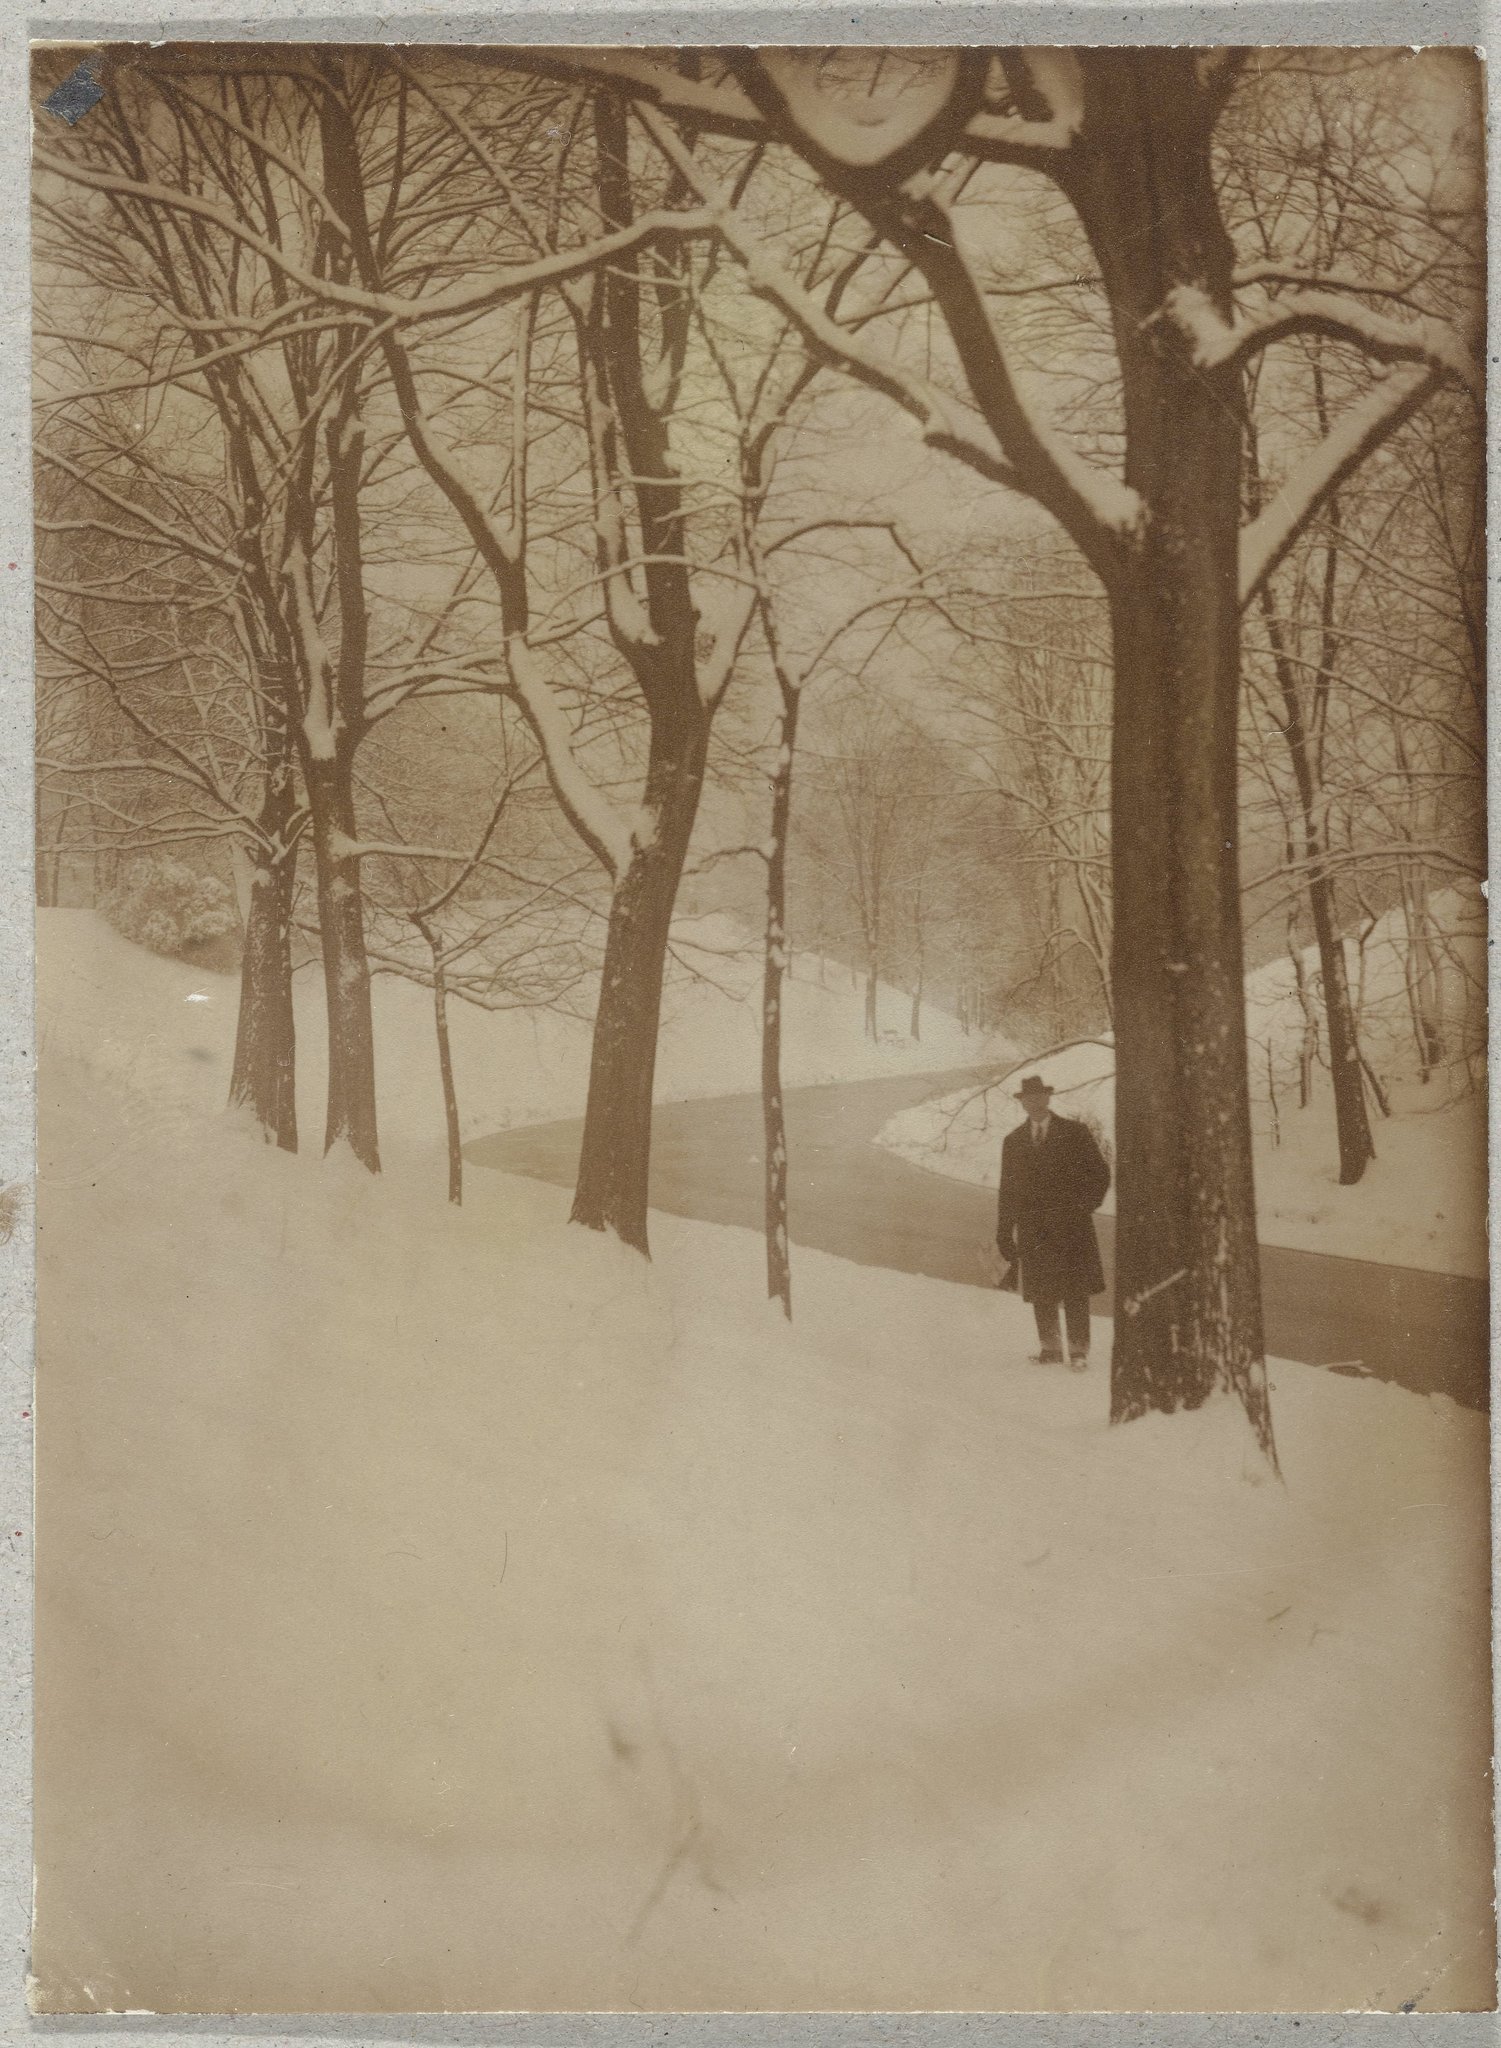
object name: photograph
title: Gezicht in het Haagse Bos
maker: Anonymous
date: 1923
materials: photographic support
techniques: gelatin silver print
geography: netherlands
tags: forest, wood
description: Gekocht als serie van 6 foto's (RP-F-2005-40 t/m 45) die verkocht werden als 'Haagse Bos, 1923'